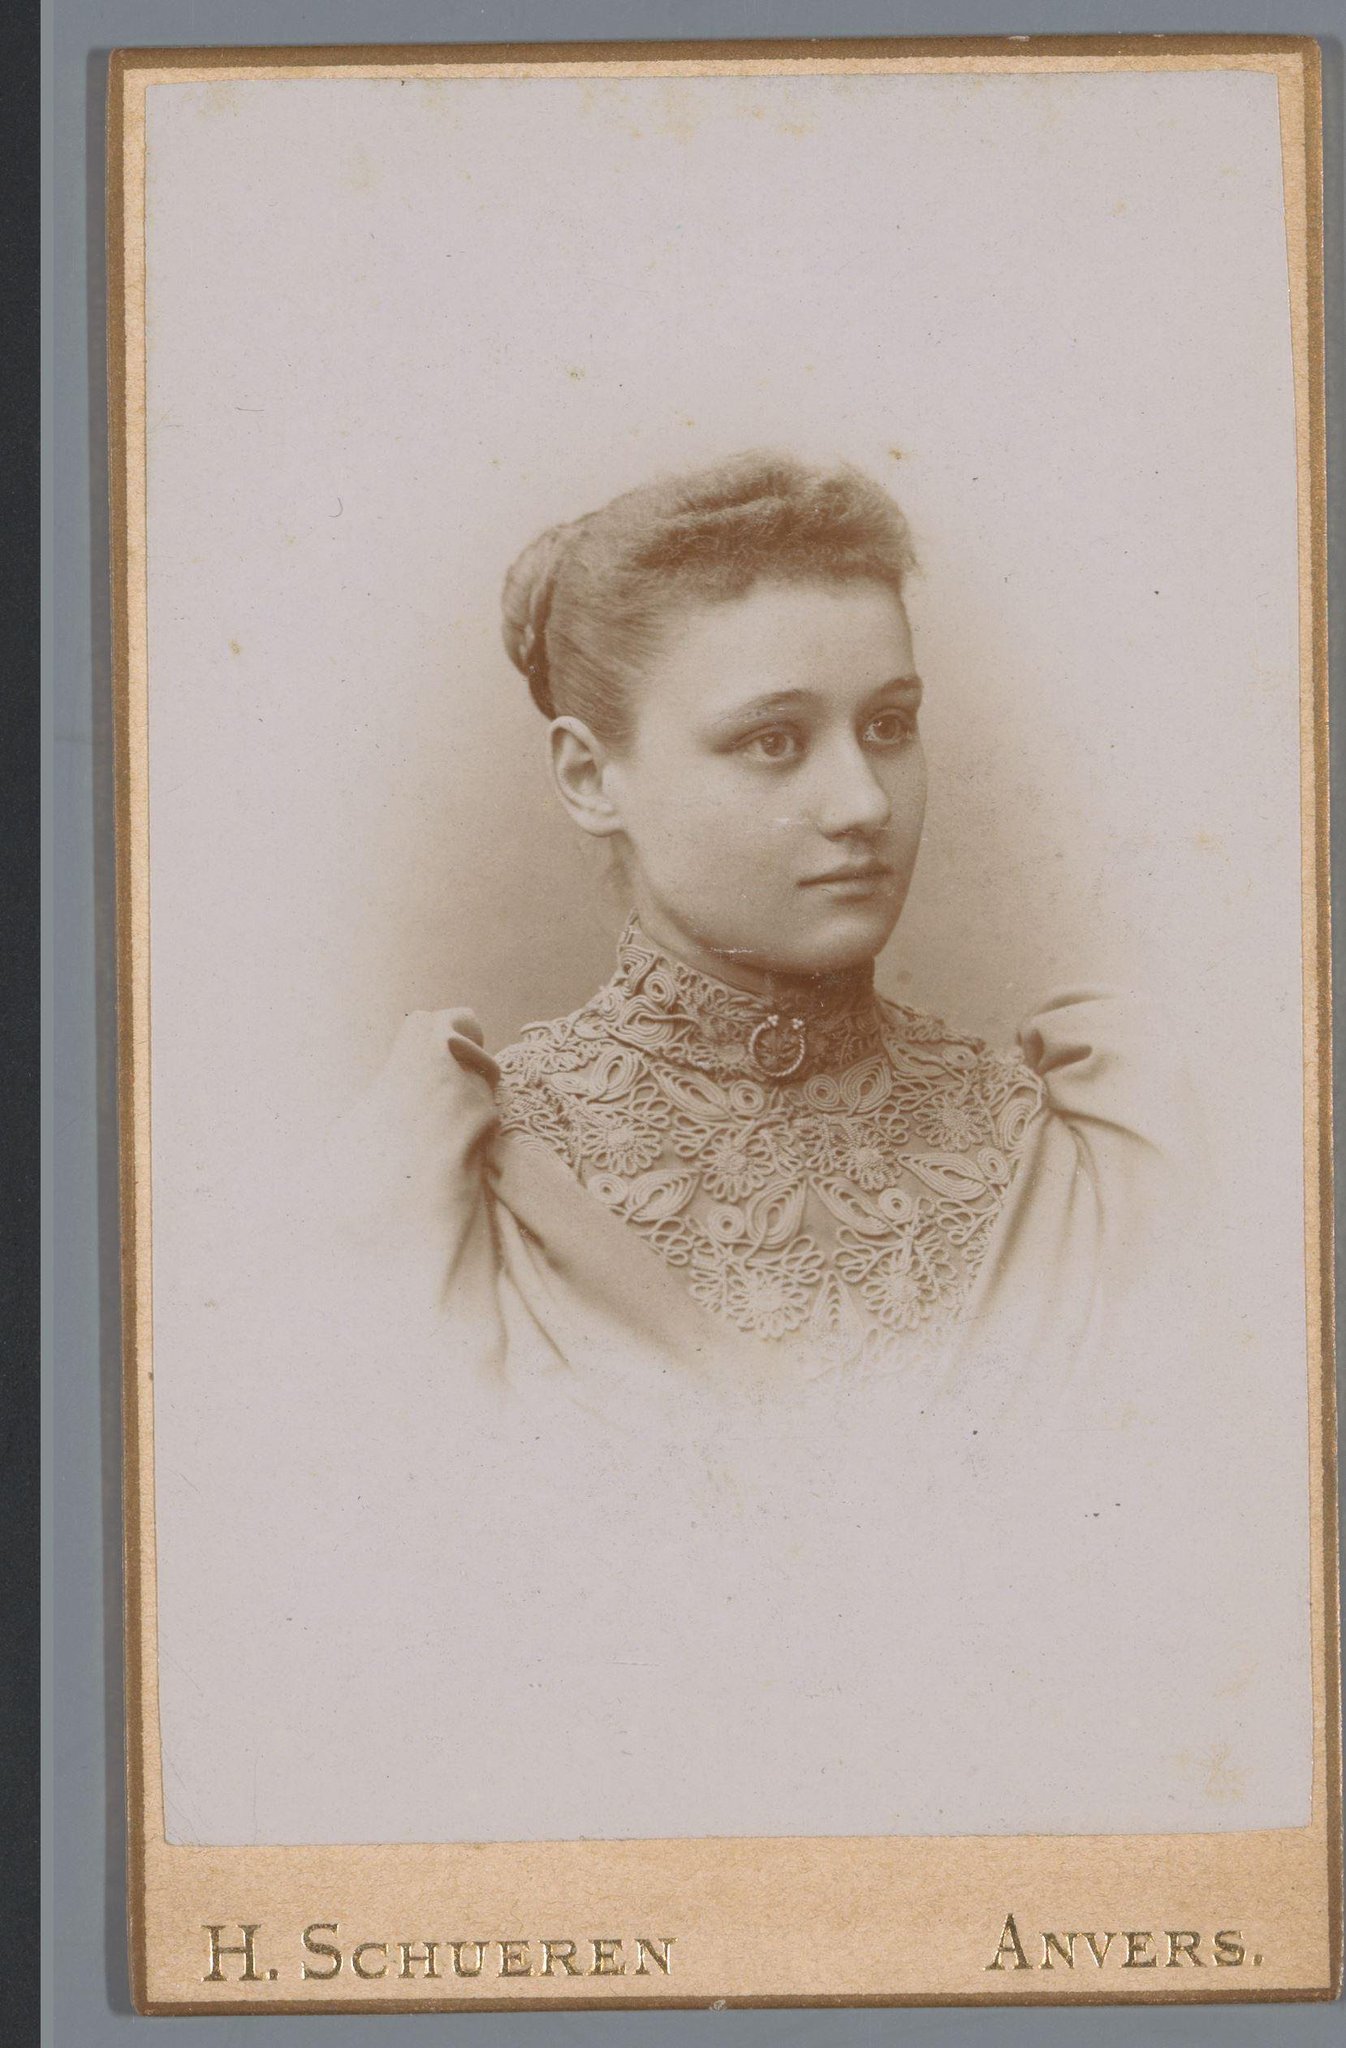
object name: carte de visite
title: Portret van een onbekende vrouw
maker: henri schüren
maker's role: fotograaf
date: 1888-1900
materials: cardboard, photographic support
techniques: daylight paper print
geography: antwerp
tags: historical persons - bb - woman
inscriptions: inscription: ‘Vergrooting op doek./ Oogenblikkelijke trekking./ Photographie artistique/ HENRI SCHUEREN/ 45, Huidevetterstraat/ ANTWERPEN.’, number: ‘23064’